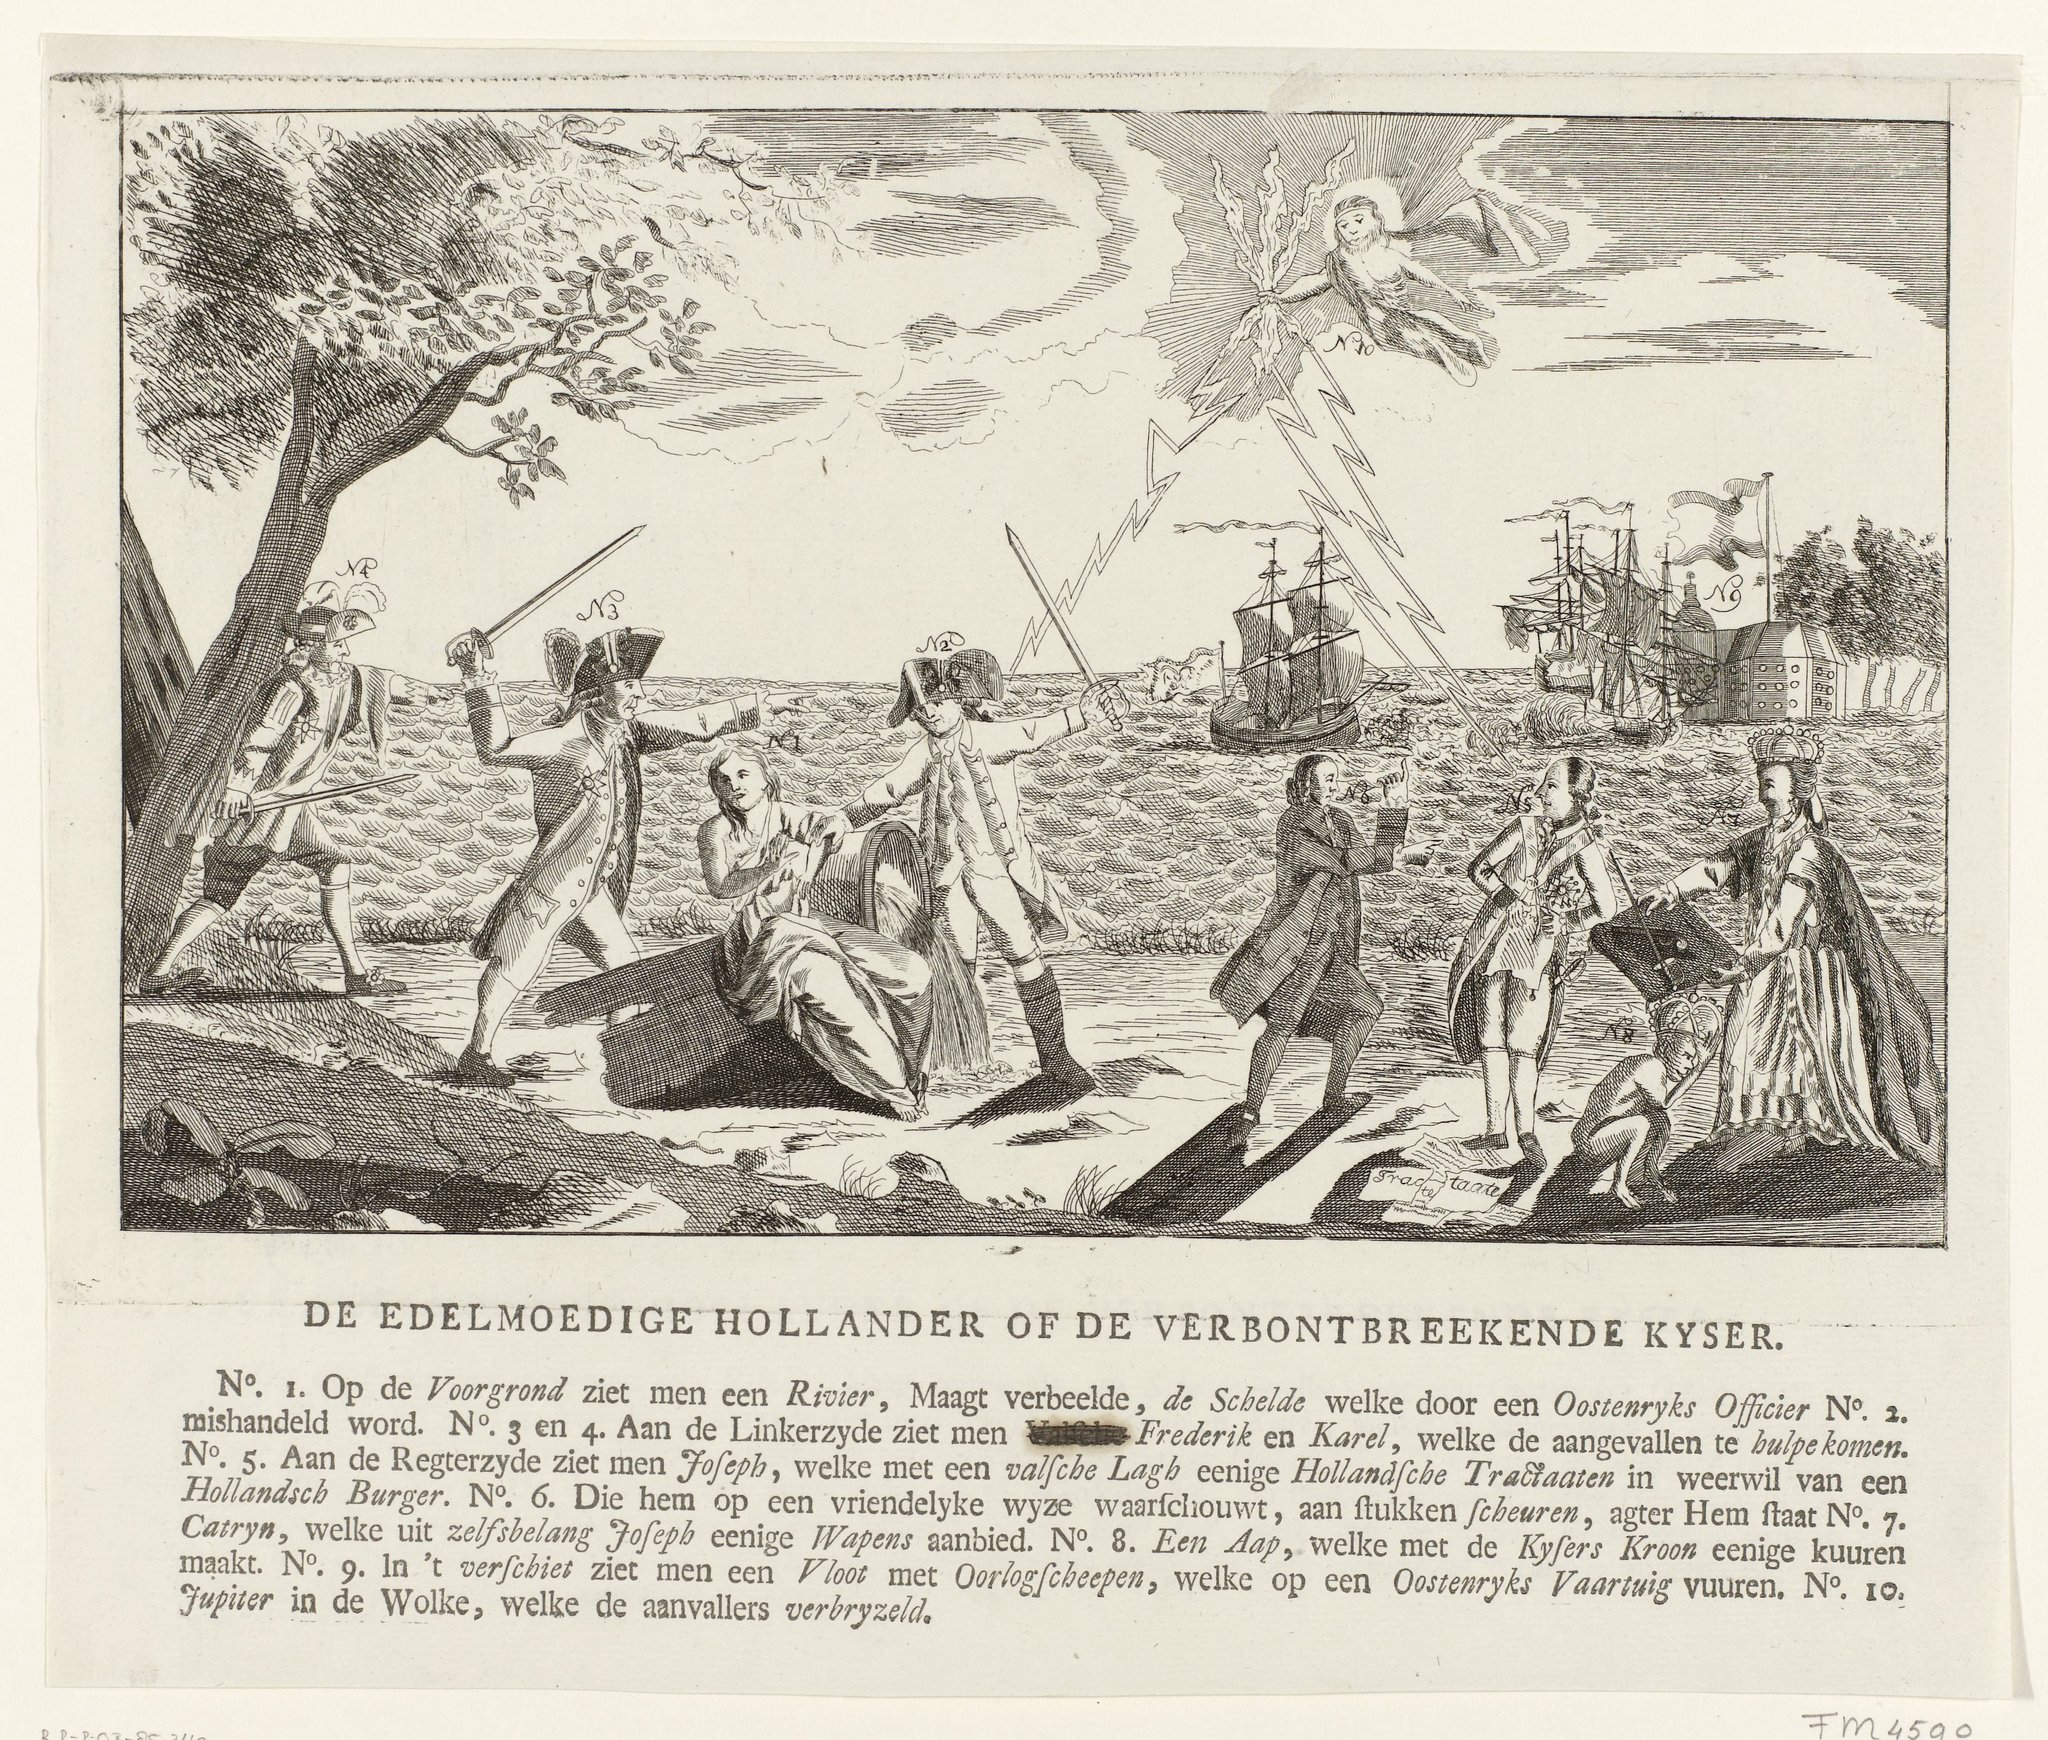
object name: cartoon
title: De Edelmoedige Hollander of de Verbontbreekende Kyser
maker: Anonymous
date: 1784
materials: paper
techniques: engraving, etching, letterpress printing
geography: northern netherlands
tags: vienna, jozef ii (duits keizer), catharina de grote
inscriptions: collector's mark: Lugt 2228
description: Spotprent op het geschil tussen de Staten-Generaal en de Duitse keizer Jozef II over het recht op vrije doorvaart op de Schelde. De Scheldemaagd wordt aangevallen door een Oostenrijkse officier; rechts waarschuwt de Hollandse Burger de keizer die tractaten heeft verscheurd, hierbij ook de Russische keizerin Catharina en een aap met een keizerskroon. Op de achtergrond het incident met de keizerlijke brik Louis en de Nederlandse schoener Dolphijn op 8 oktober 1784. Op het blad onder de plaat een uitleg van de cijfers 1-10 in de voorstelling.